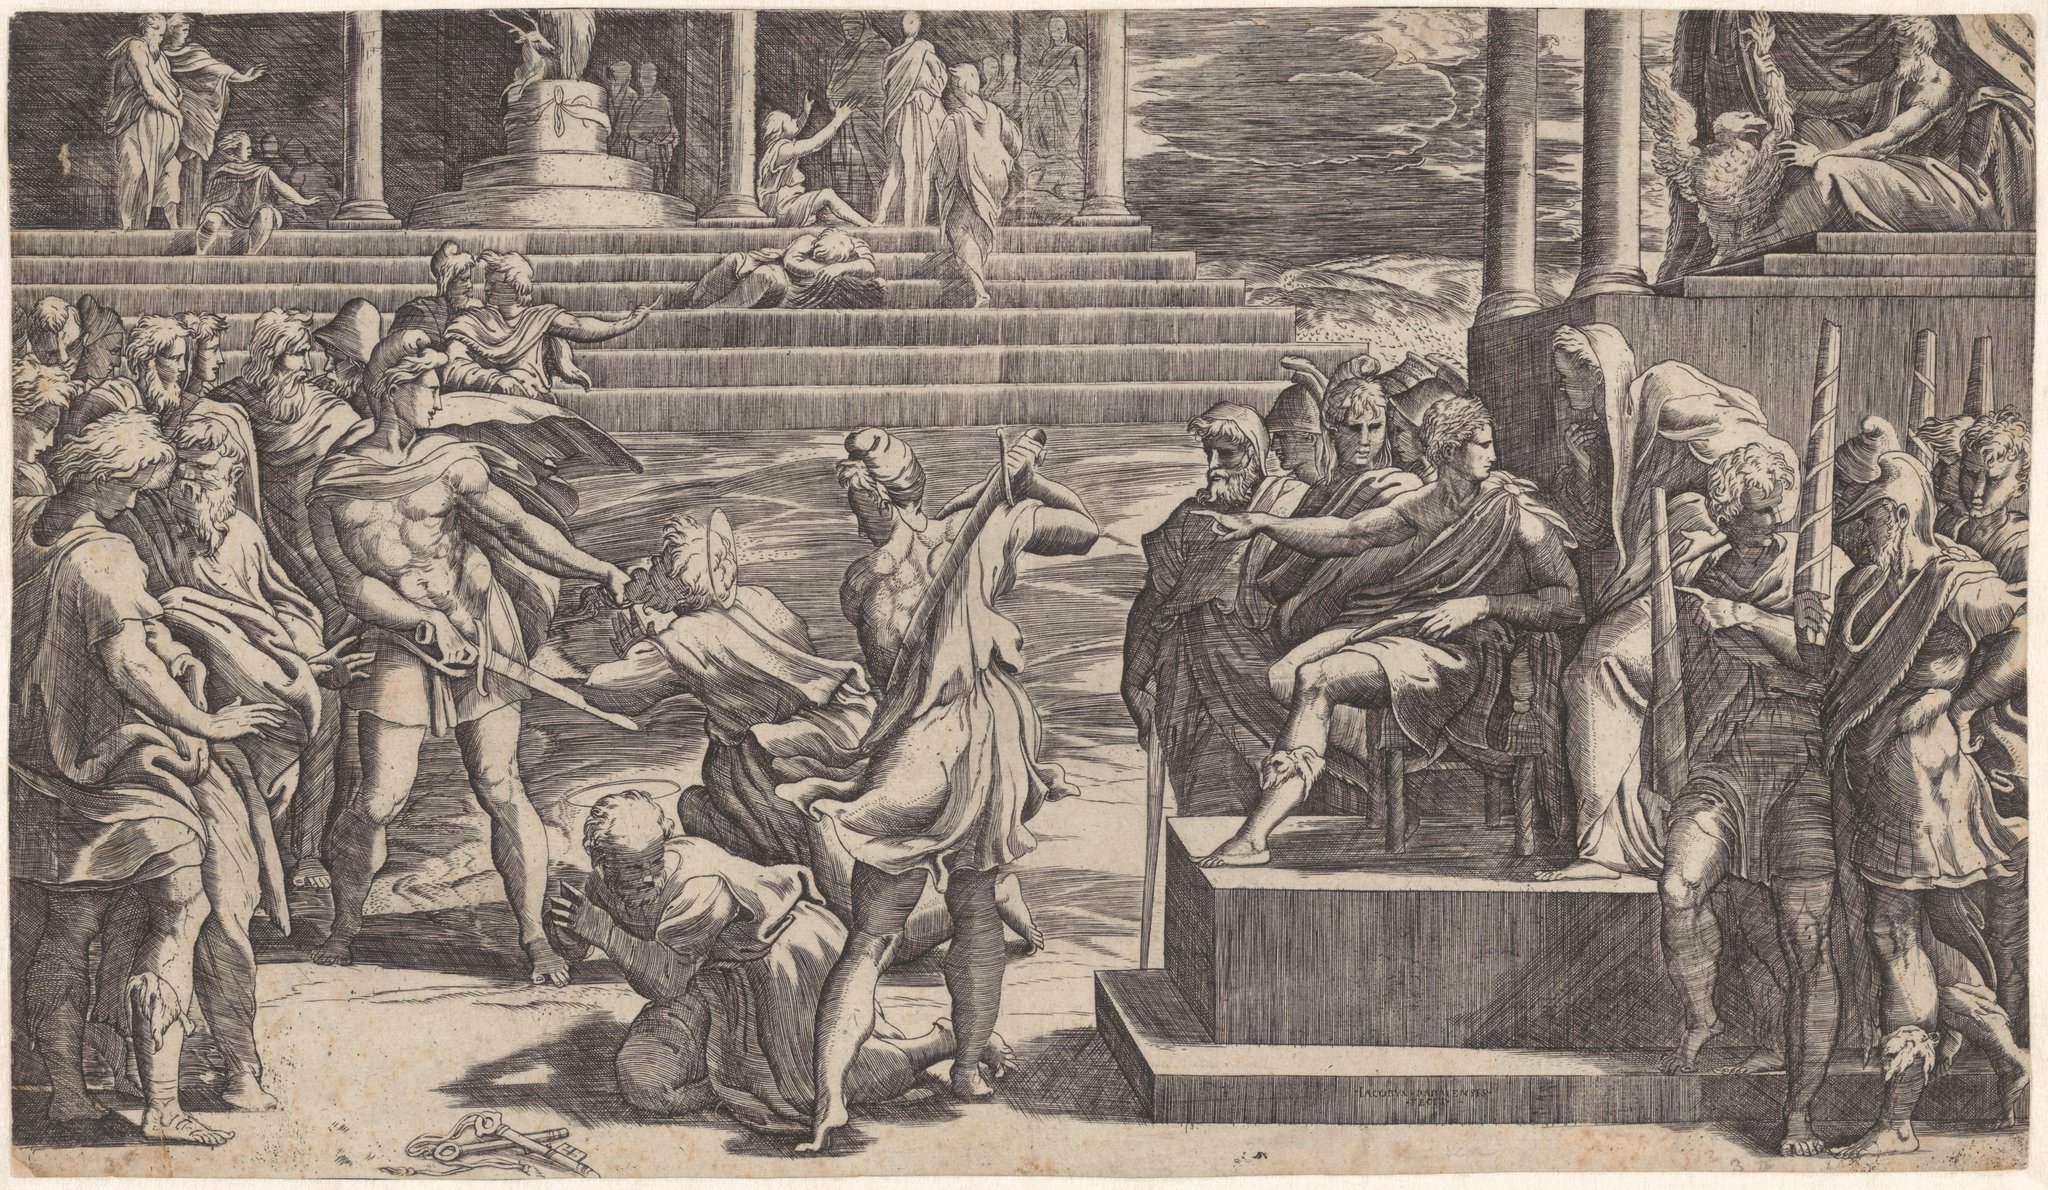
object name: print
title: The martyrdom of Saint Paul and the condemnation of Saint Peter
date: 1525-1527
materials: paper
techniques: engraving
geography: italy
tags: martyrdom and death of peter, martyrdom and death of paul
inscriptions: collector's mark: Lugt 2760, collector's mark: Lugt 2228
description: De apostel Paulus knielt voor zijn onthoofding, Petrus wordt door een beul meegetrokken. Rechts een Romeinse keizer op zijn troon.